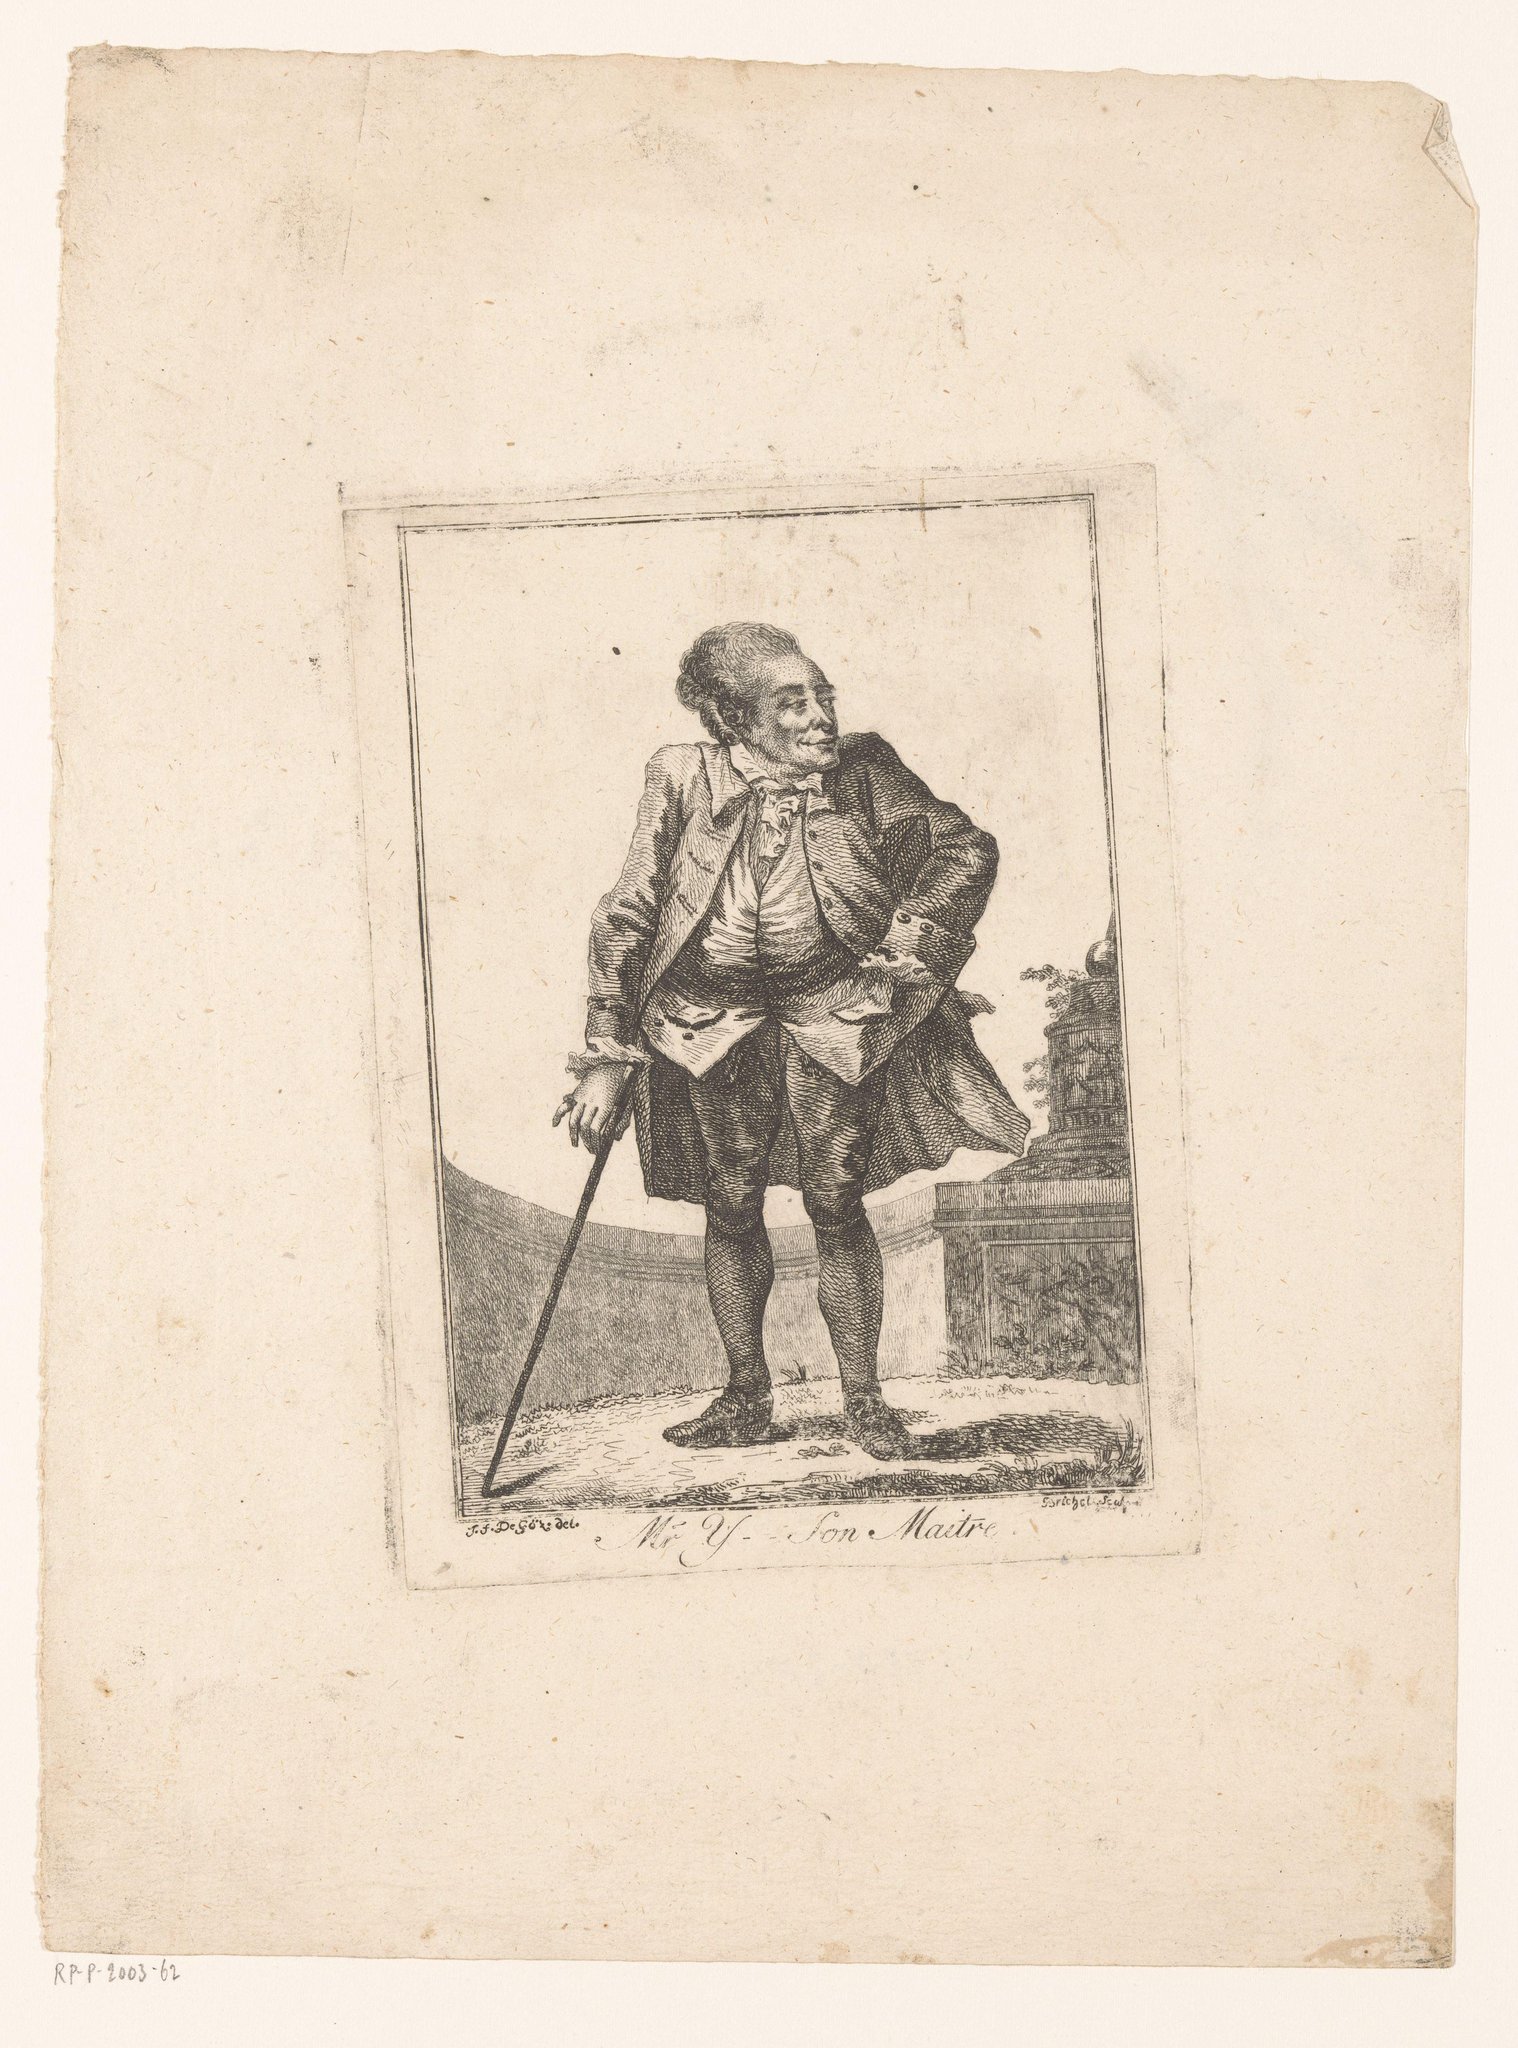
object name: print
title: Exercises d'imagination de differens Caractères et Formes humaines (...)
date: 1783-1784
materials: paper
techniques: etching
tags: coat: overcoat, walking-stick, staff, adult man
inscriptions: collector's mark: Lugt 2228, collector's mark: Lugt 2760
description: Prent uit een serie getiteld: "Exercises d'imagination de differens Caractères et Formes humaines inventés peints et dessinés par J. F. de Goez Suite 1", bestaande uit honderd platen met verschillende figuren met elk een eigen titel. Plaat 1 t/m 84 zijn van de hand van Brichet naar ontwerp van Von Goez en plaat 85 t/m 100 zijn door Von Goez zelf geëtst.